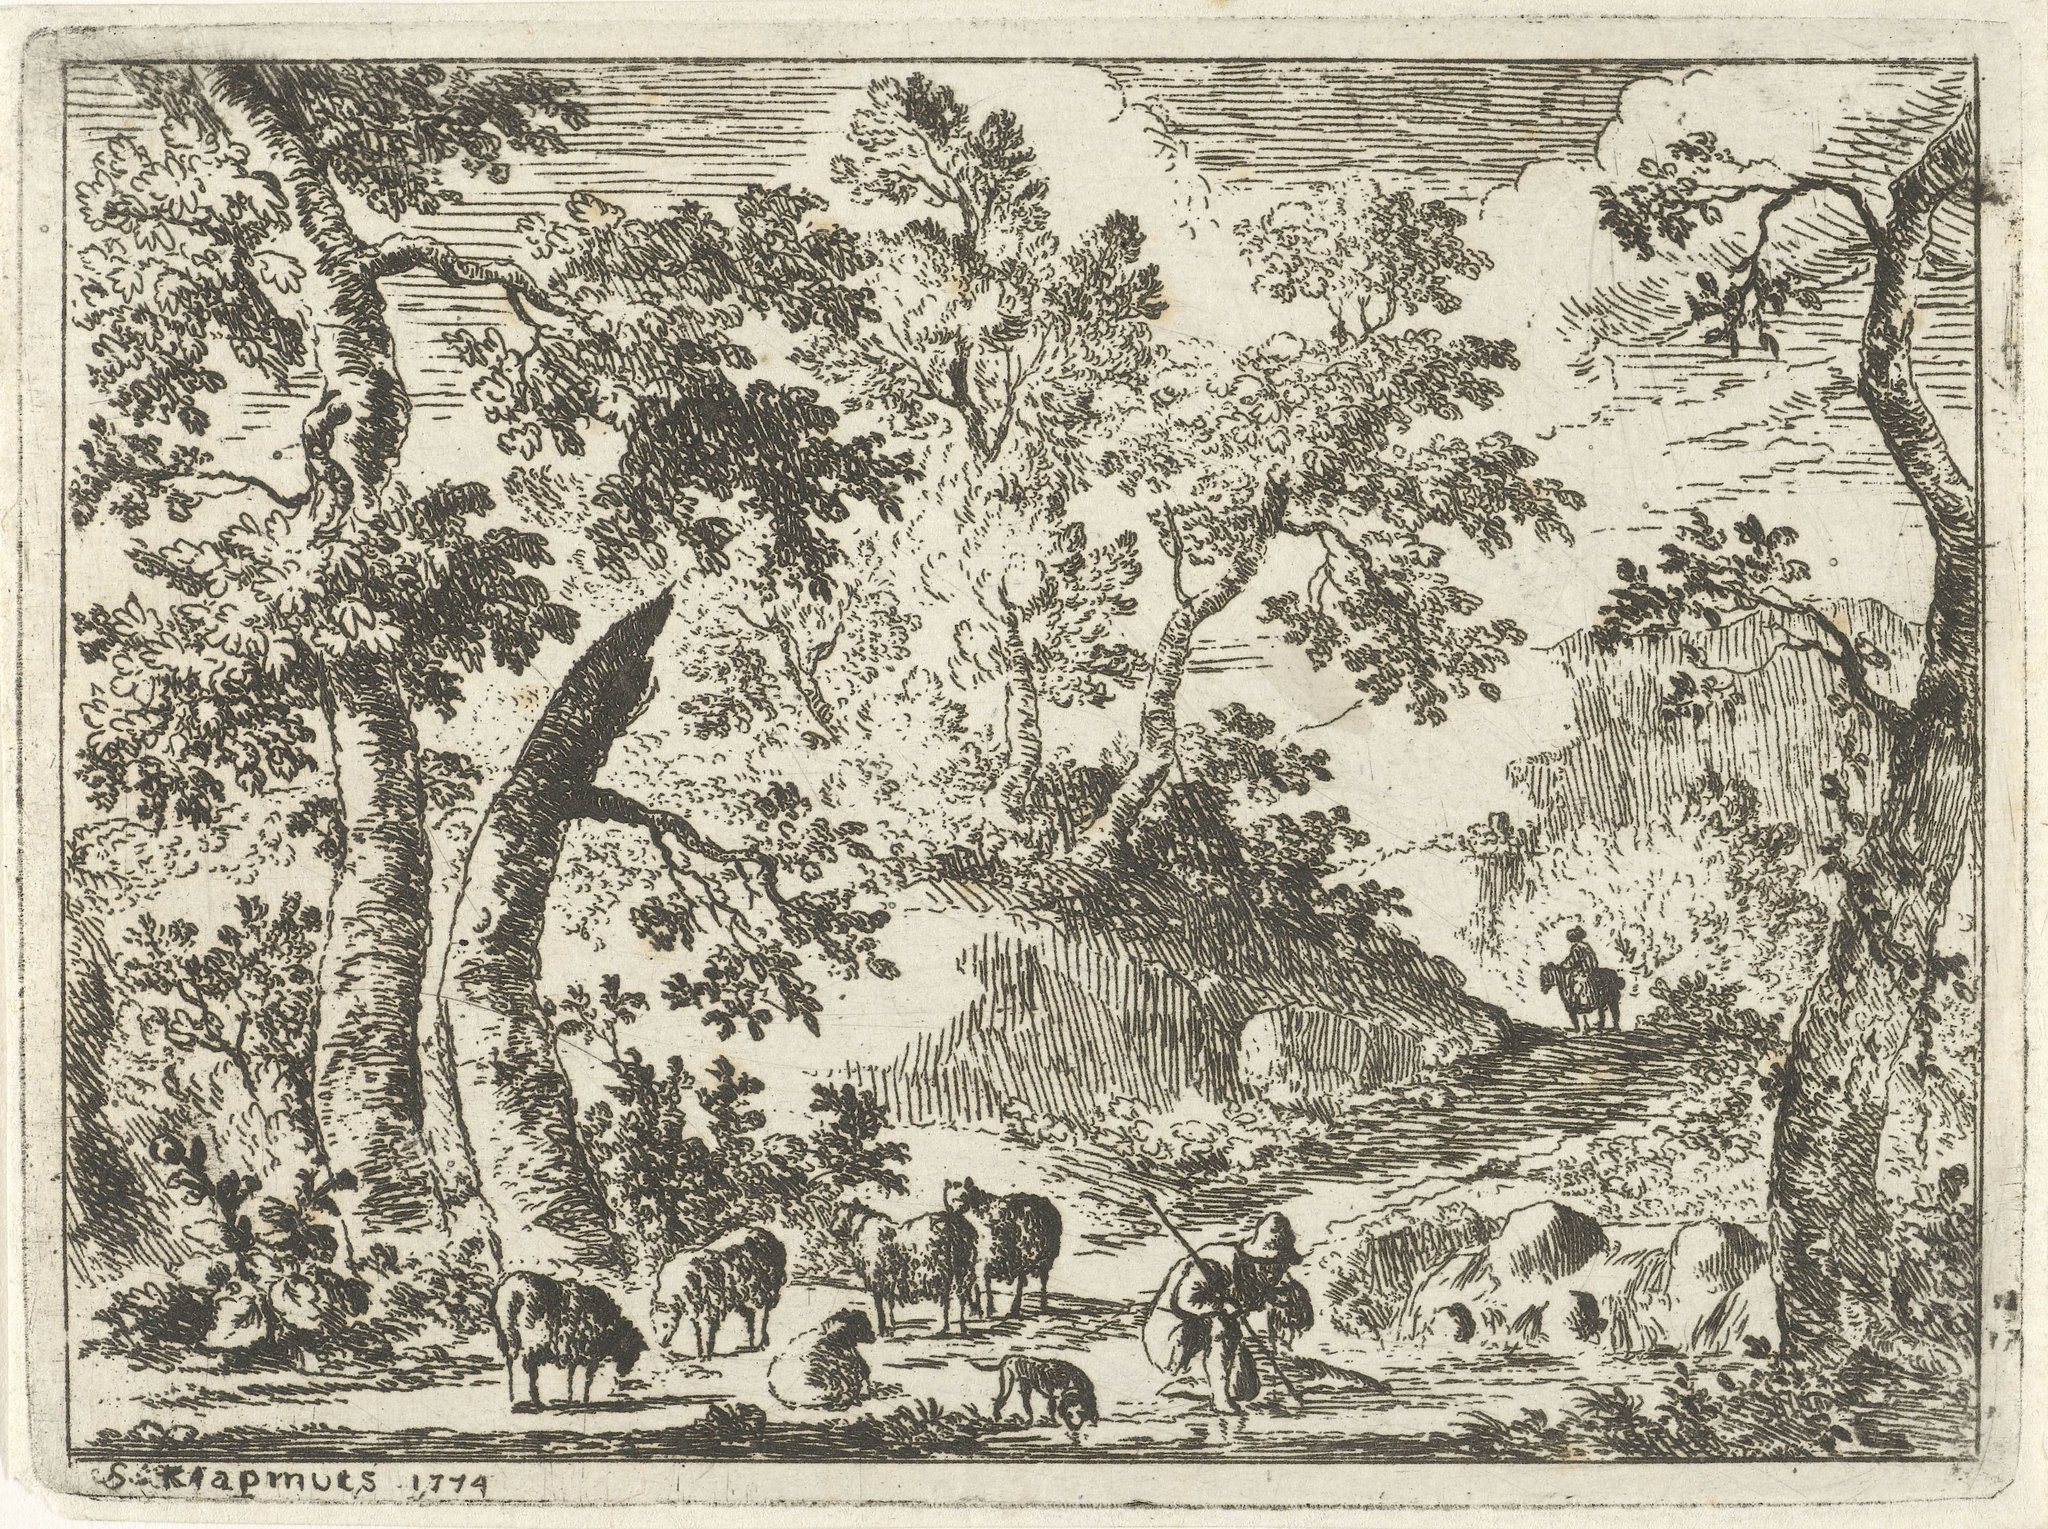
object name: print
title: Herder en schapen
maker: simon klapmuts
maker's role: print maker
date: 1774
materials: paper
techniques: etching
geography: moordrecht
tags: riding a horse, ass, or mule; rider, horseman, herding, herdsman, herdswoman, shepherd, shepherdess, cowherd, etc., forest, wood, sheep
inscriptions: collector's mark: Lugt 2165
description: Naast een landweg in een bos zit een herder geknield bij zijn kudde schapen. Op de achtergrond een ruiter.